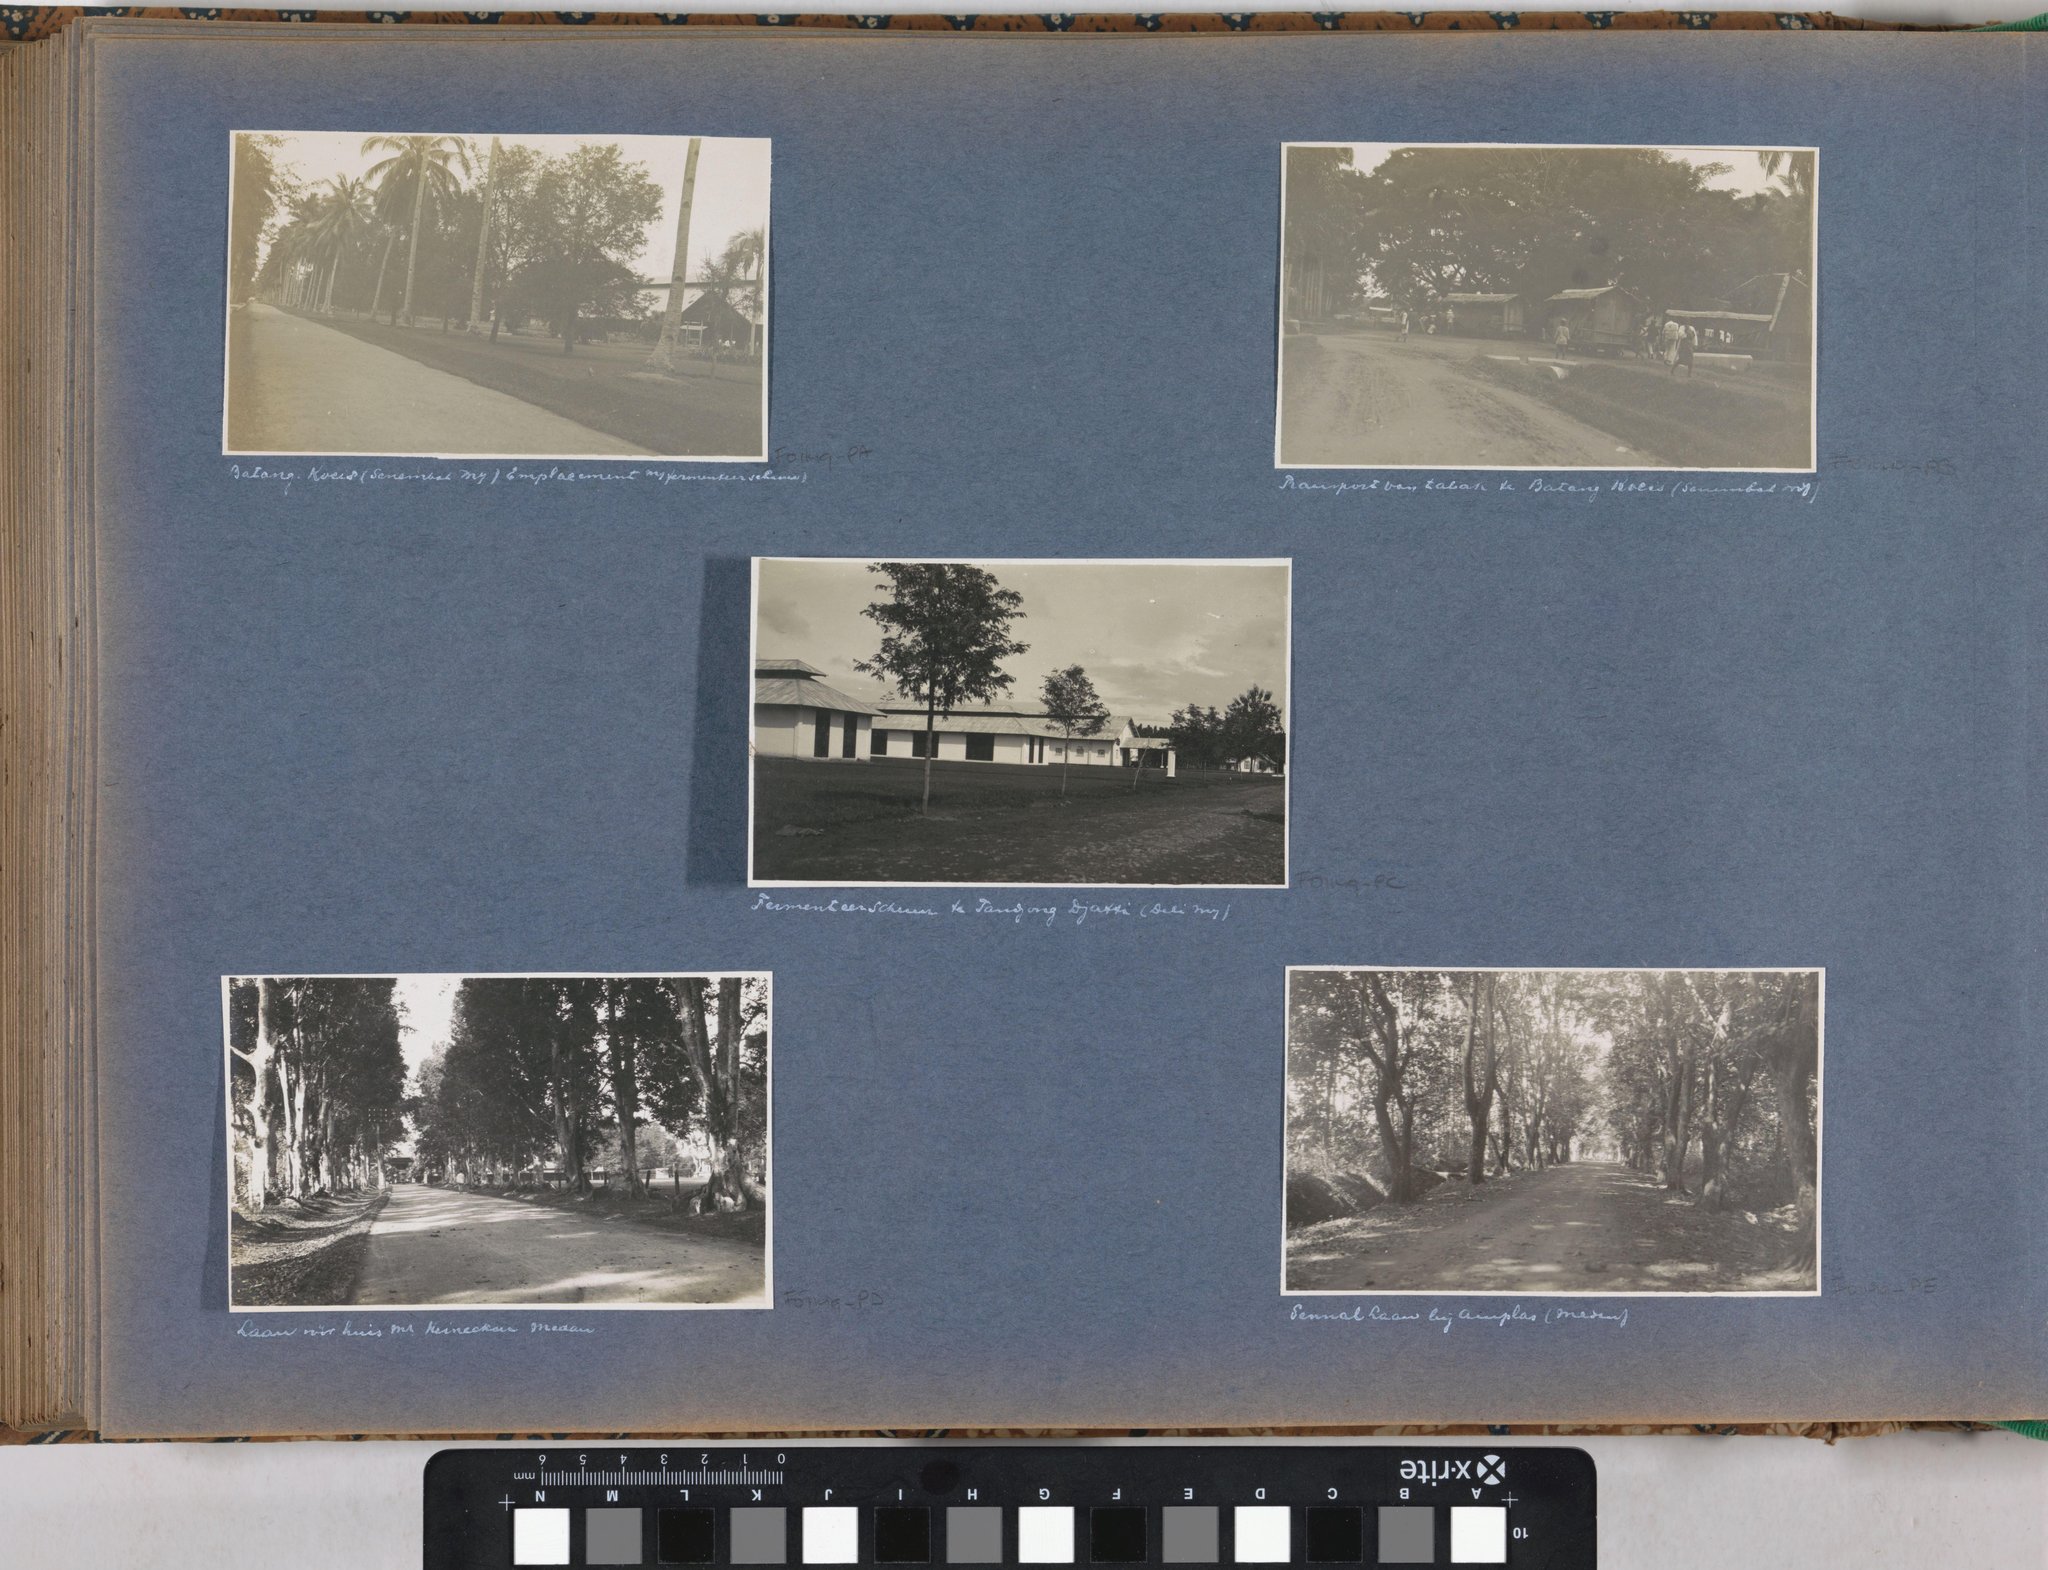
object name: photograph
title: Sennahlaan bij Amplas op Sumatra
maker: Anonymous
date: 1900-1920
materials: paper, photographic support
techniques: gelatin silver print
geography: sumatra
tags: forest path or lane, sumatra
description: Onderdeel van reisalbum met foto's van bedrijvigheid en bezienswaardigheden op Sumatra en Java en van de reis naar en van Nederlands-Indië.